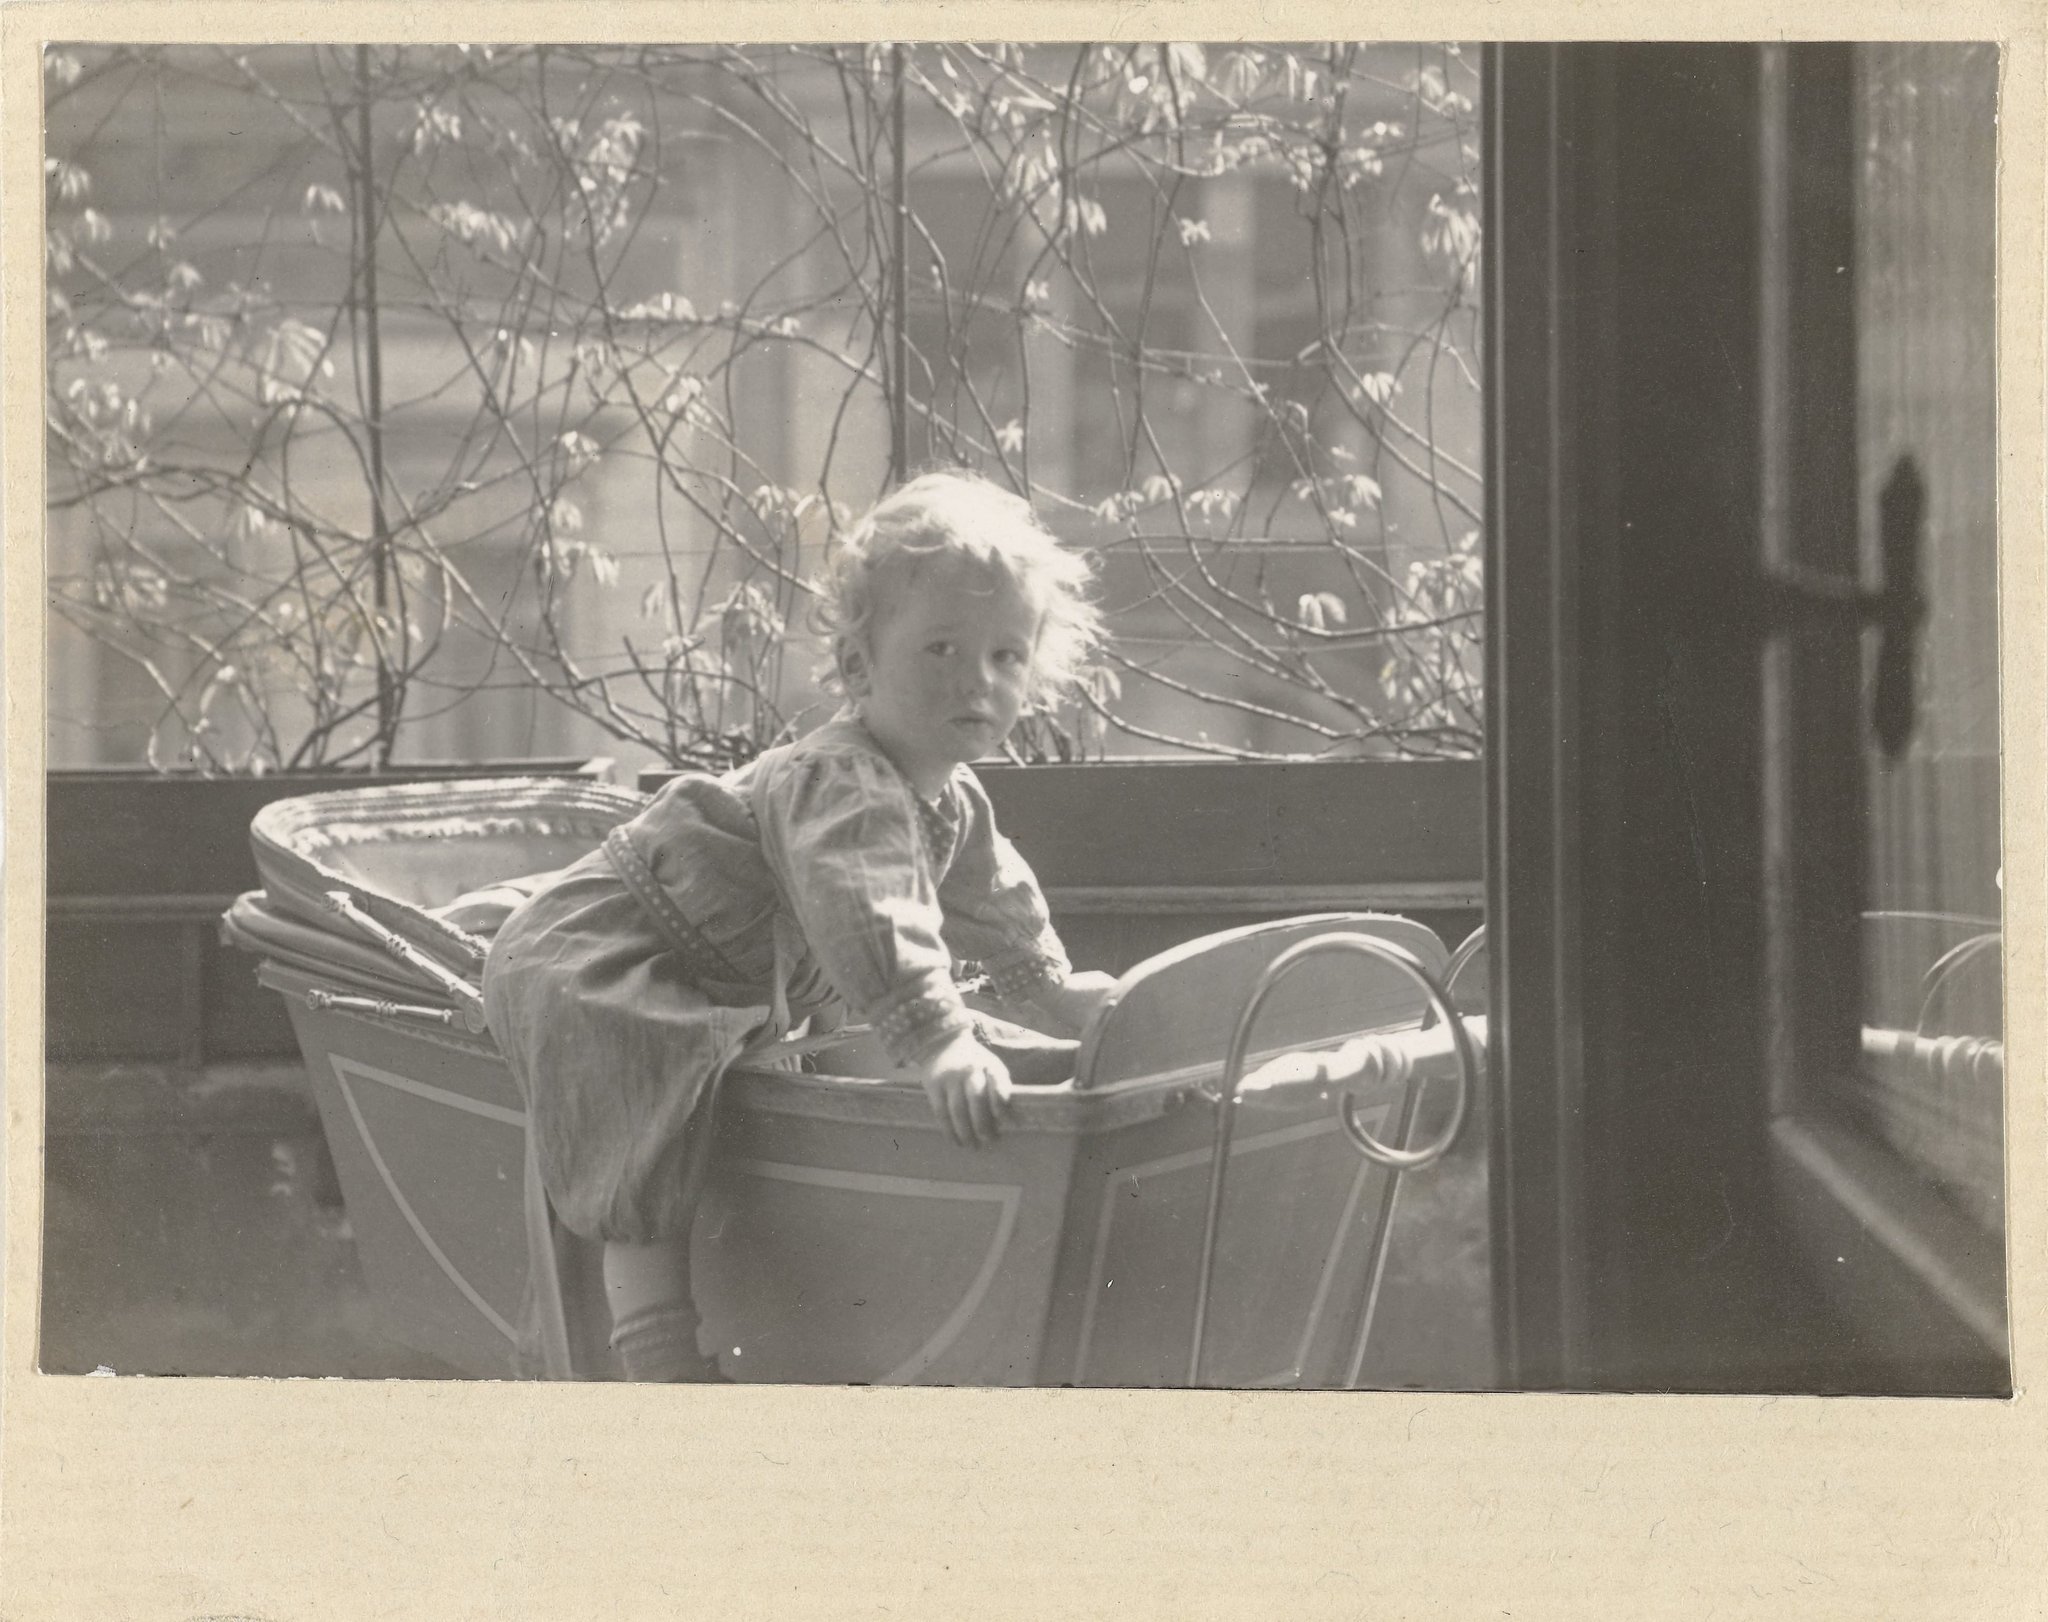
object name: photograph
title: Eckart Titzenthaler, zoon van de fotograaf, op een balkon van het woonhuis in de Friedrichstrasse, Berlijn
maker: waldemar titzenthaler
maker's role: fotograaf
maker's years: 1869-1937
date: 1917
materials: paper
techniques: gelatin silver print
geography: berlin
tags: engineer, baby-carriage, pram, perambulator, tot, toddler ~ the ages of man, berlin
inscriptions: date: ‘20.5.17’